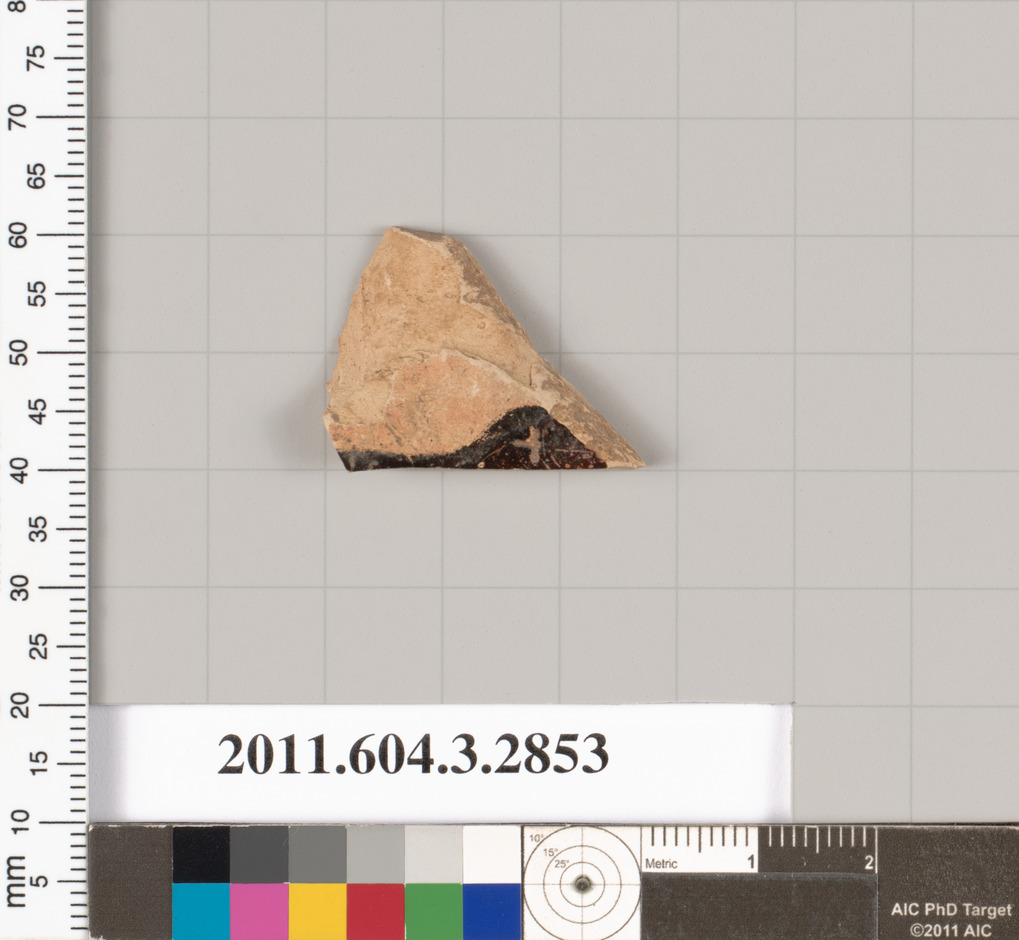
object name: undetermined closed shape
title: Terracotta fragment of a closed shape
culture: greek, attic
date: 534-468 BCE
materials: terracotta